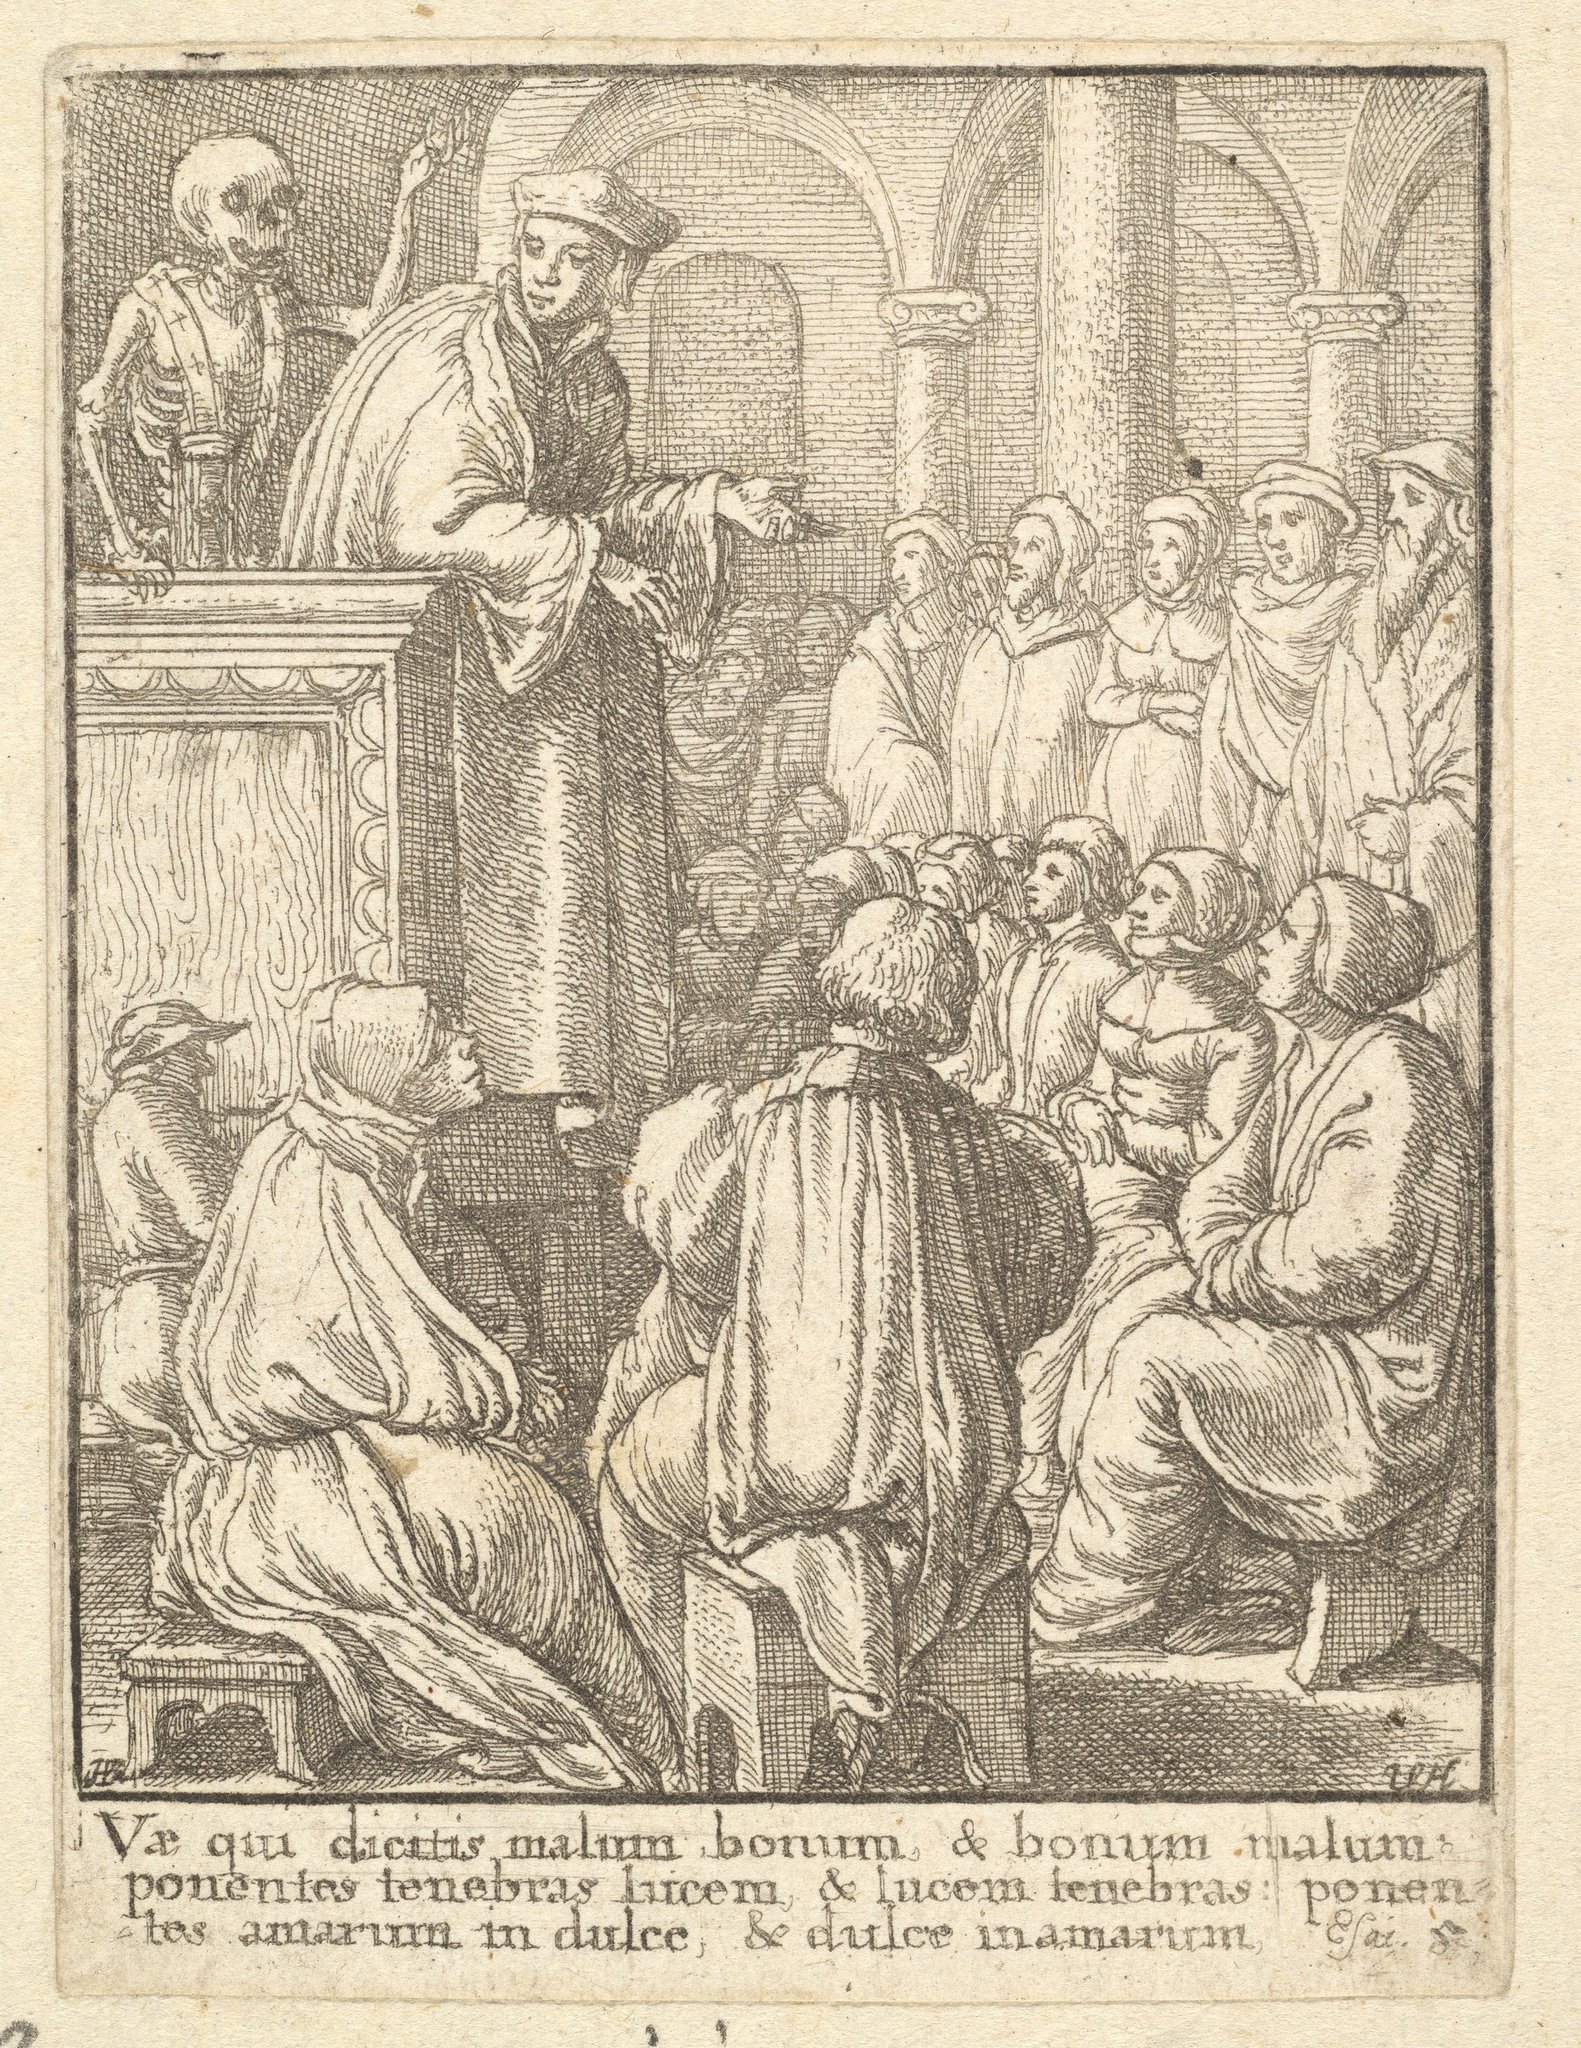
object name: print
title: Preacher, from the Dance of Death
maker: wenceslaus hollar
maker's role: artist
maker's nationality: bohemian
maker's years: 1607-1677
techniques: etching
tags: skeletons,crowd